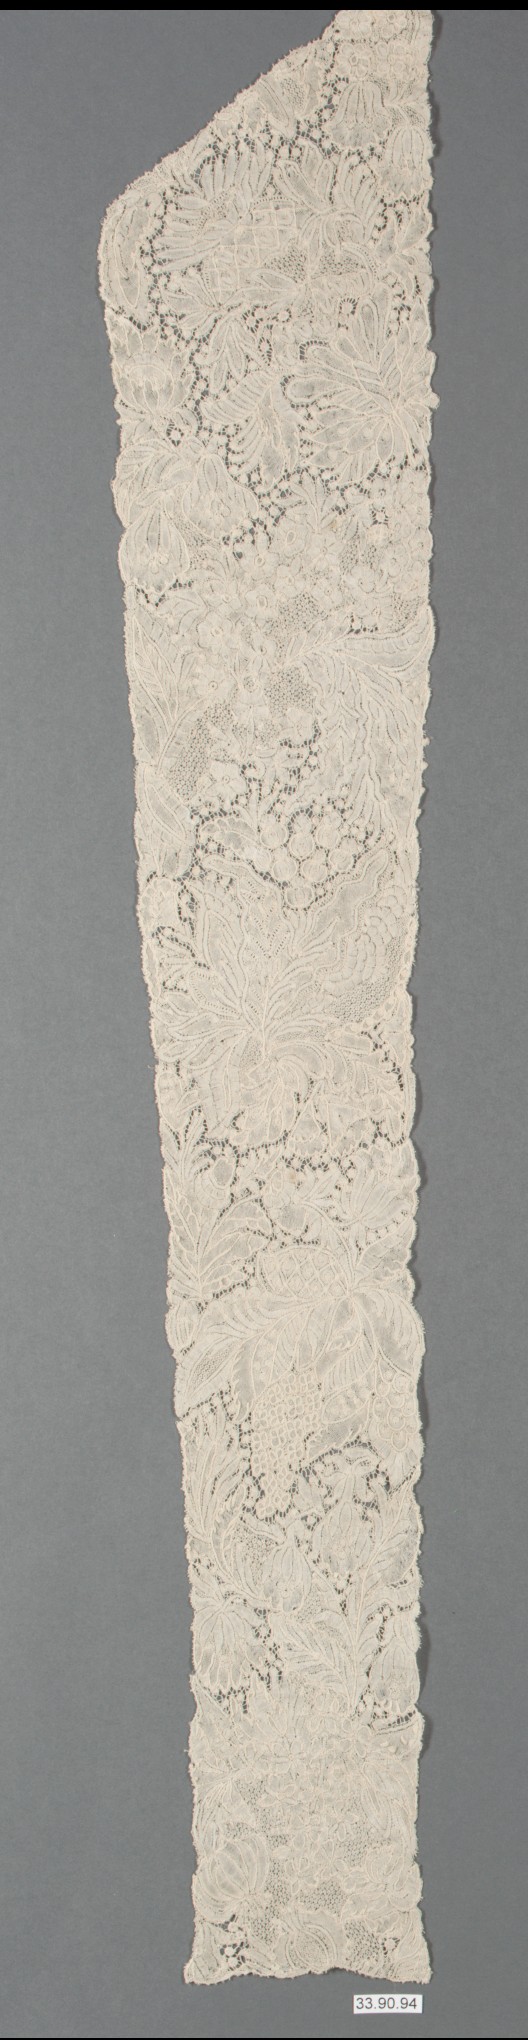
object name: lappet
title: Lappet (one of a pair)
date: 1701-1733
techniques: lace